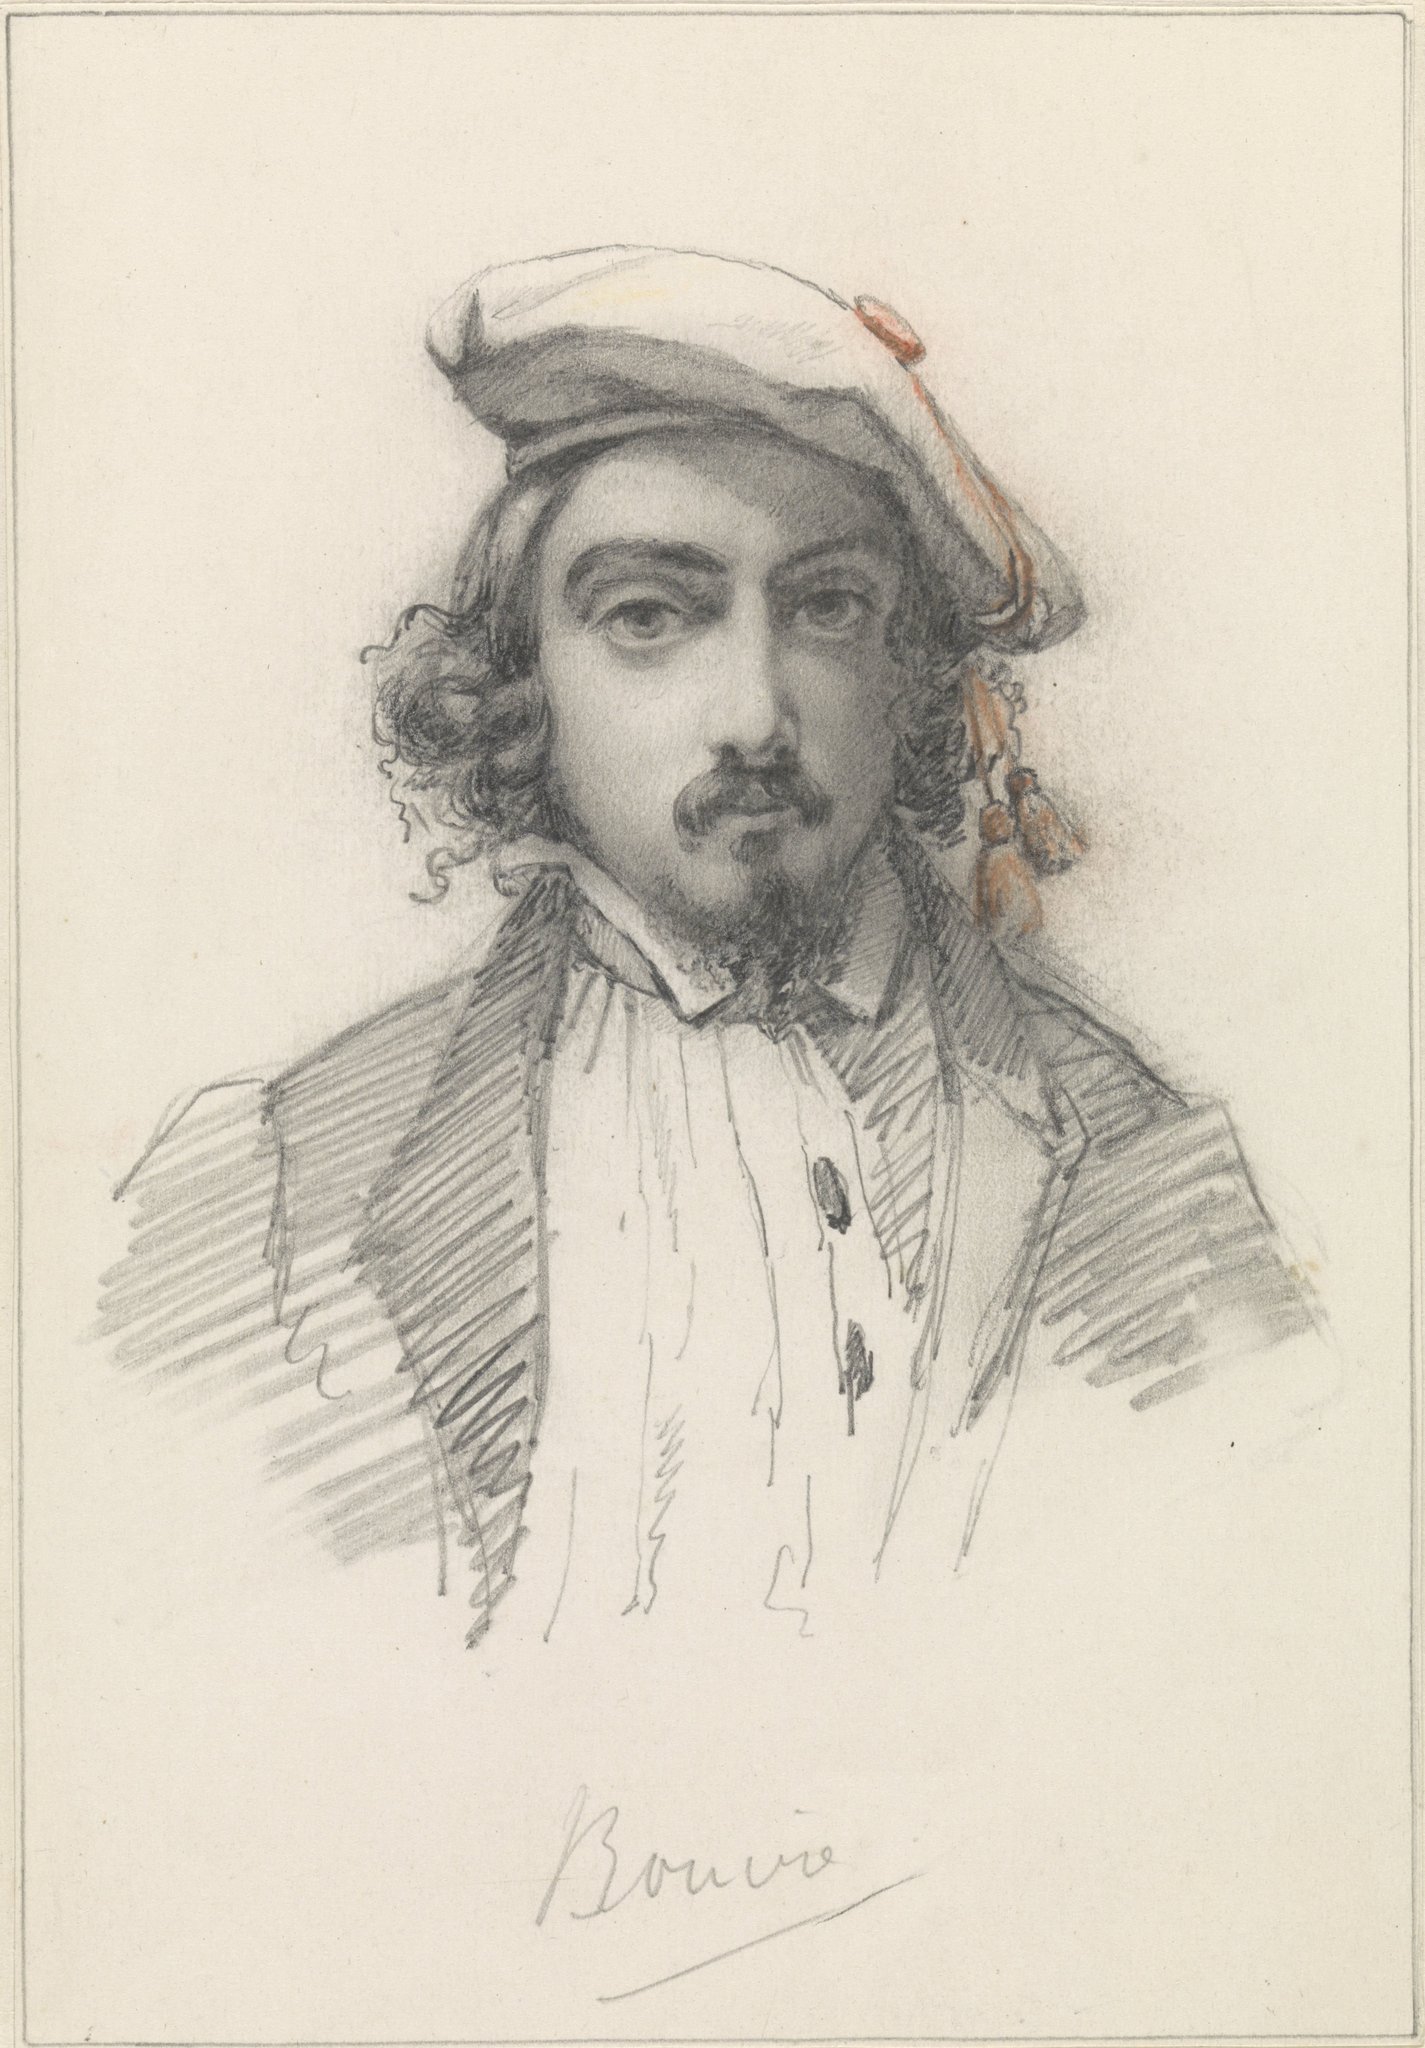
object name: drawing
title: Zelfportret van Felix Bovie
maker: félix bovie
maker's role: draughtsman, print maker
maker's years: 1812-1880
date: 1822-1880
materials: chalk, paper, pencil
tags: brussels, print maker, draughtsman, félix bovie, historical persons, portrait, self-portrait of painter, portrait, self-portrait of artist, portrait, self-portrait of draughtsman